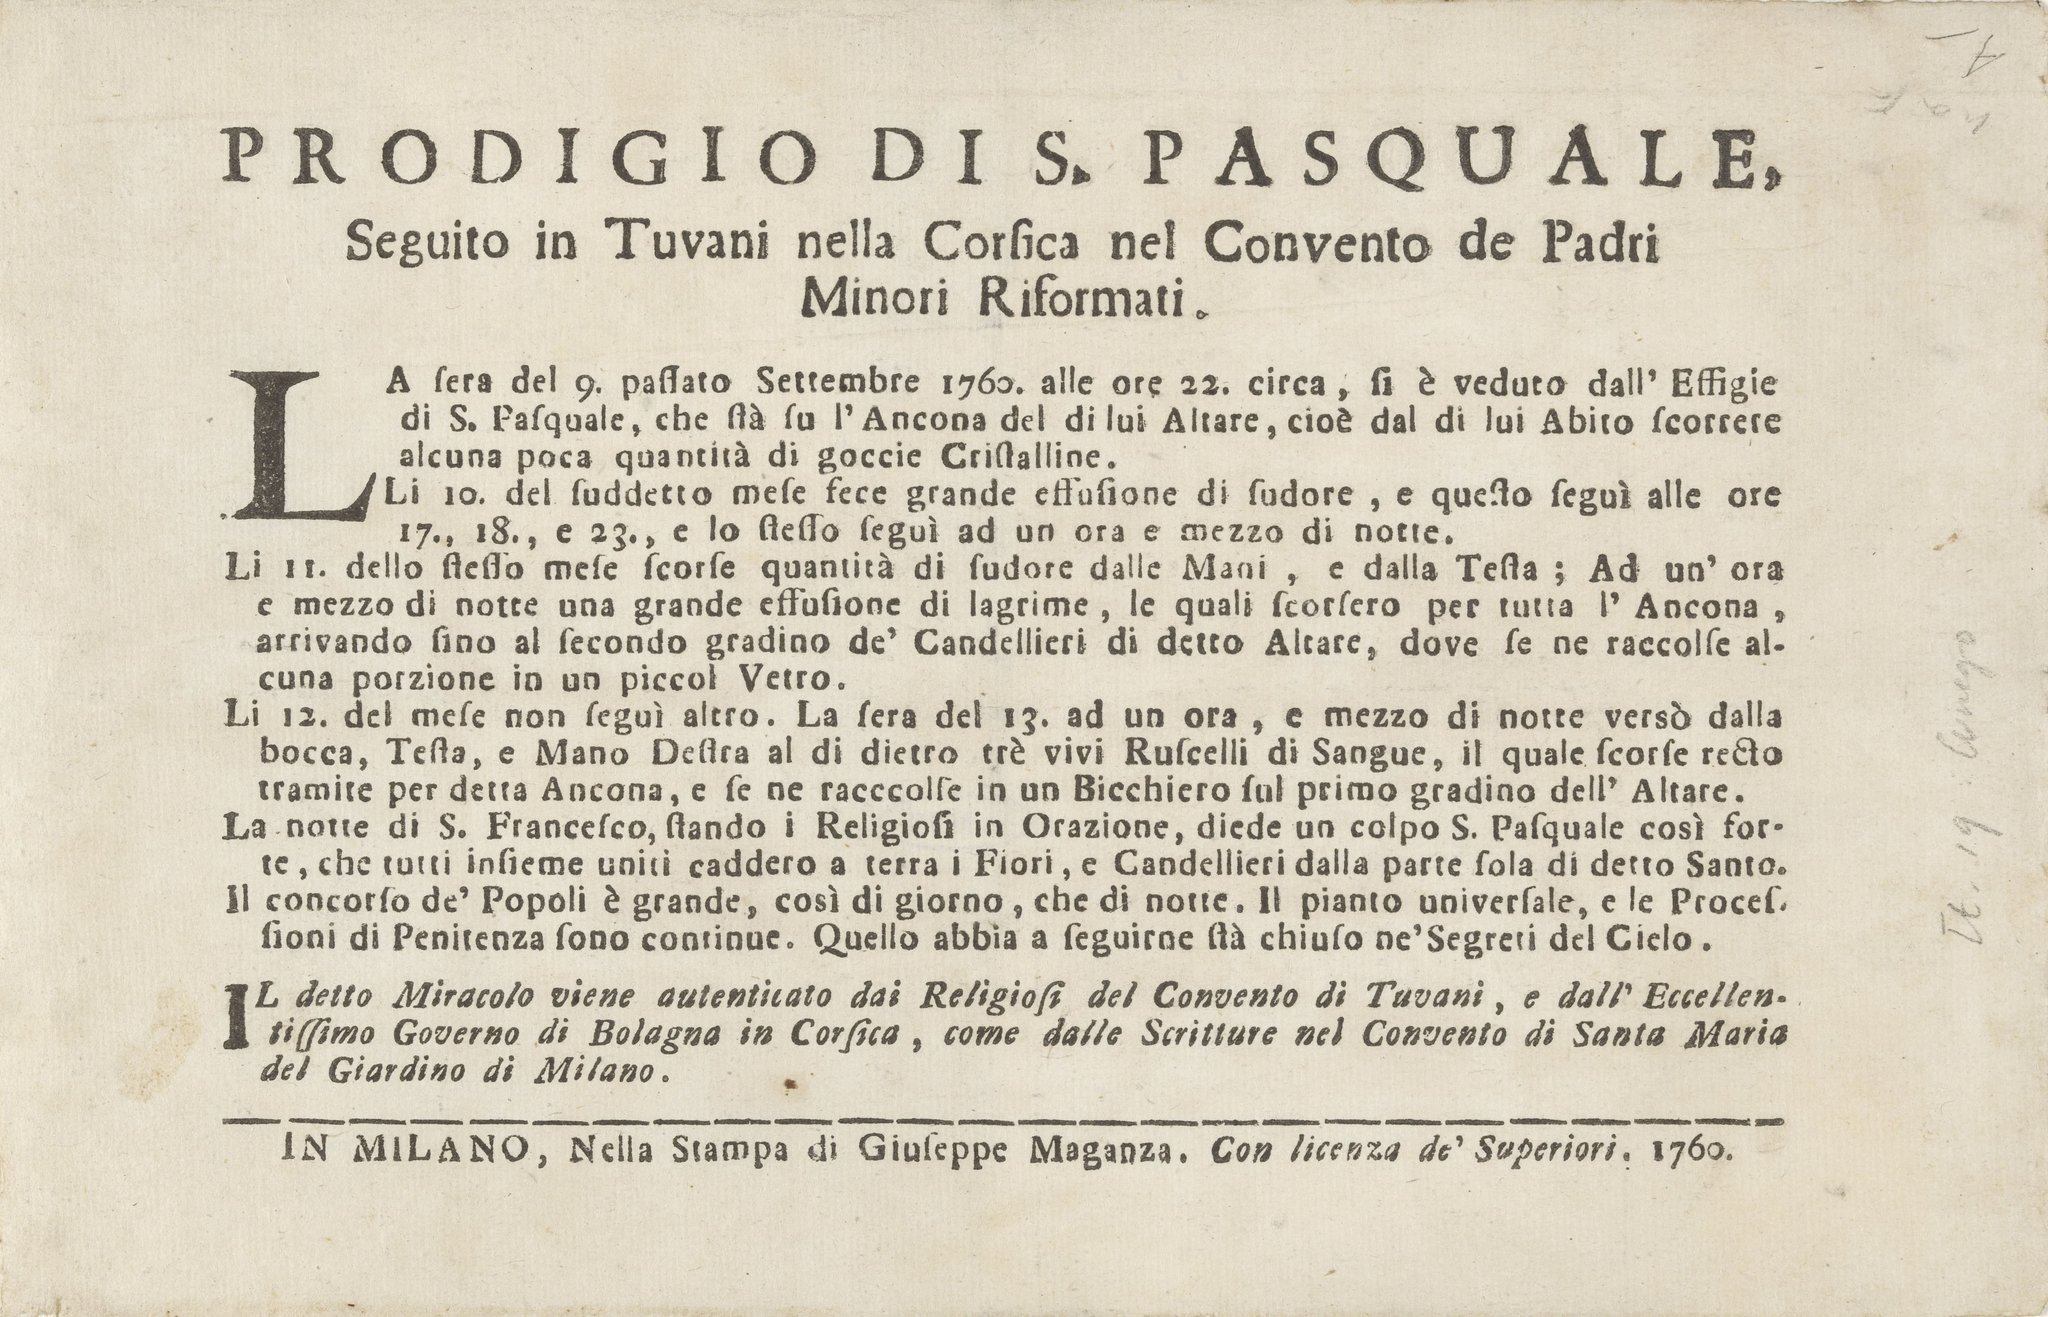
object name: text sheet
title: Prodigio dis. Pasquale, / Seguite in Tuvani nella Corsica nel Convento de Padri / Minori Riformati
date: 1760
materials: paper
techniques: letterpress printing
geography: italy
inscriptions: collector's mark: Lugt 2228